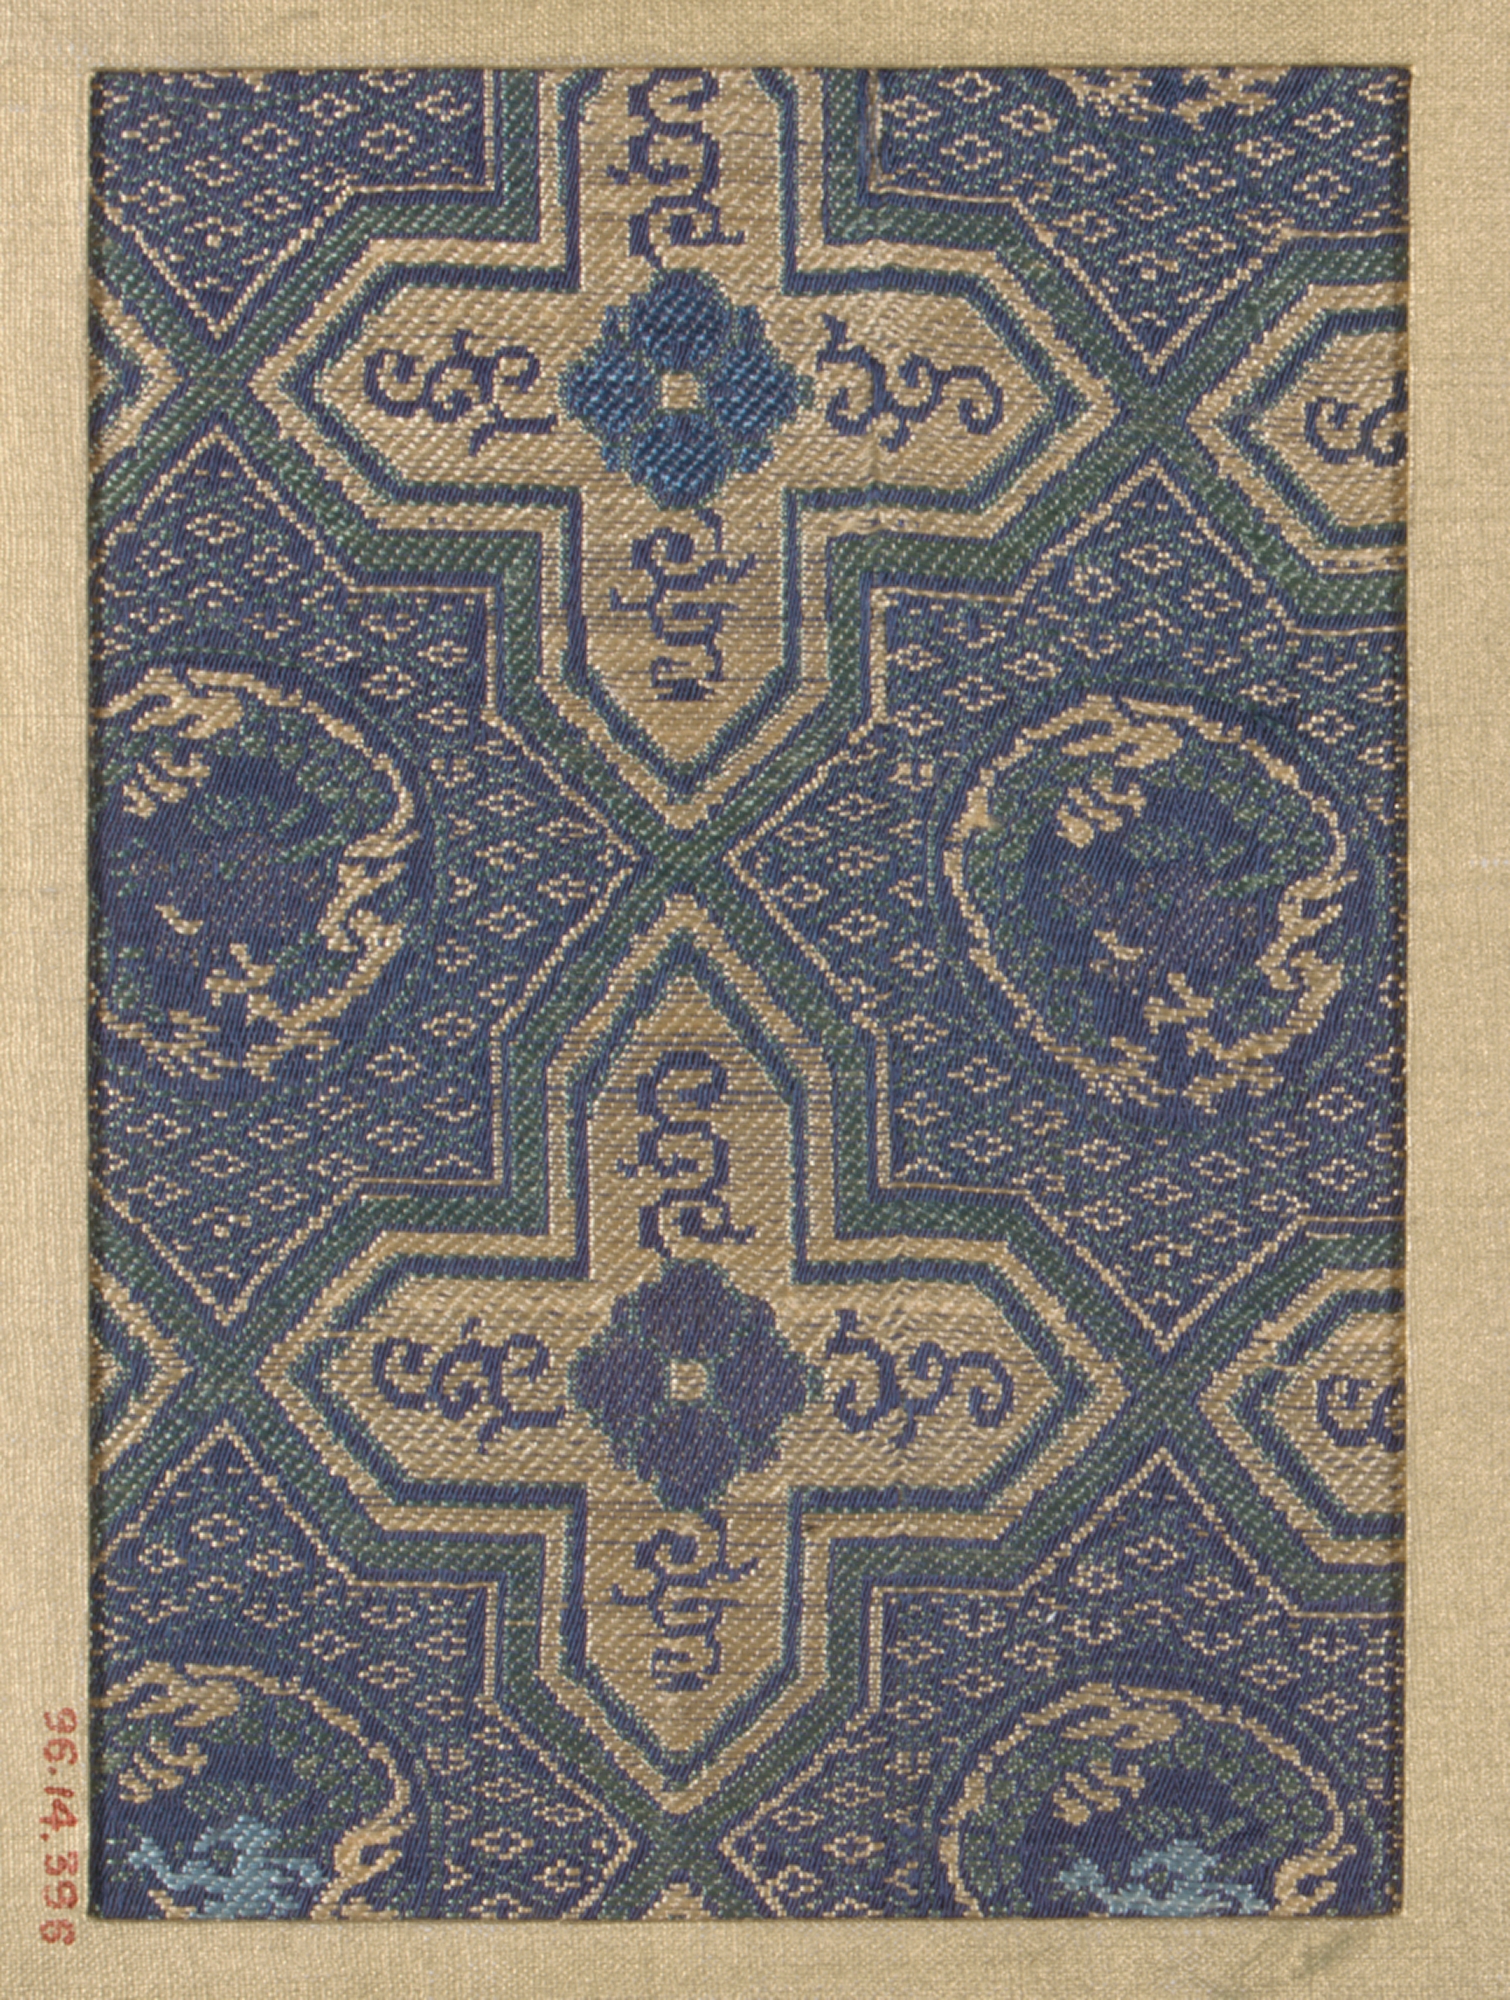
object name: piece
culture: japanese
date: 1701-1900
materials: silk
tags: dragons